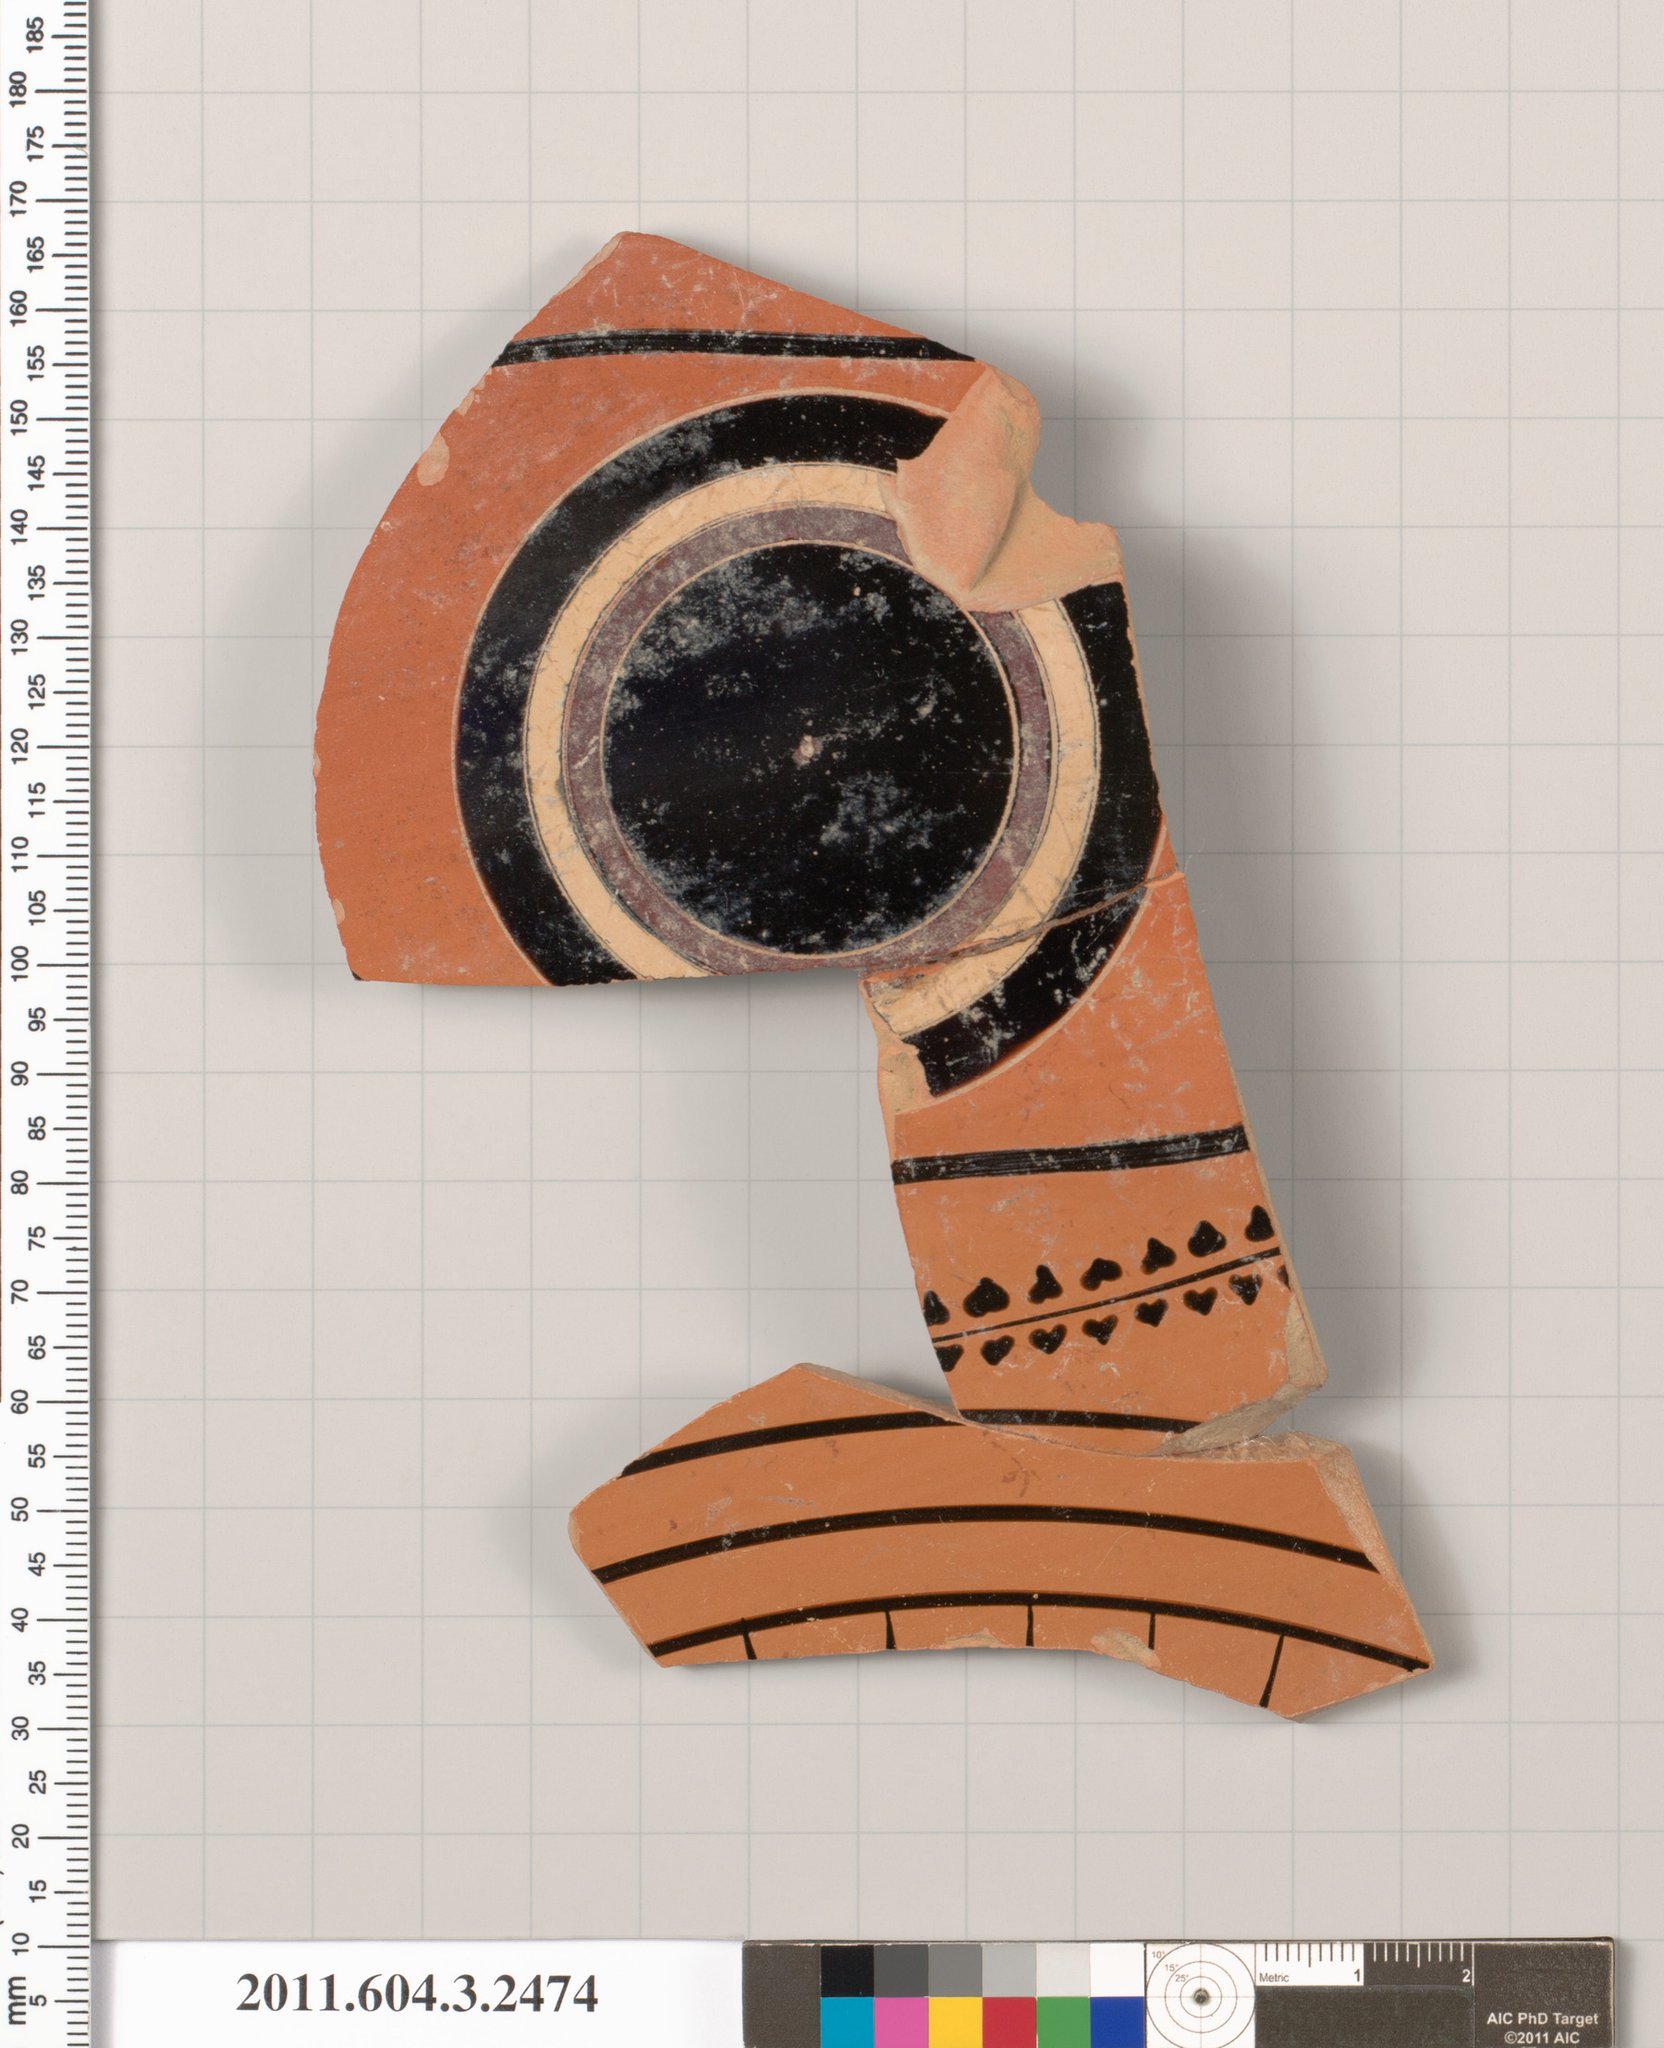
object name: kylix fragment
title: Terracotta fragment of a kylix: eye-cup (drinking cup)?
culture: greek, attic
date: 520-510 BCE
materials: terracotta